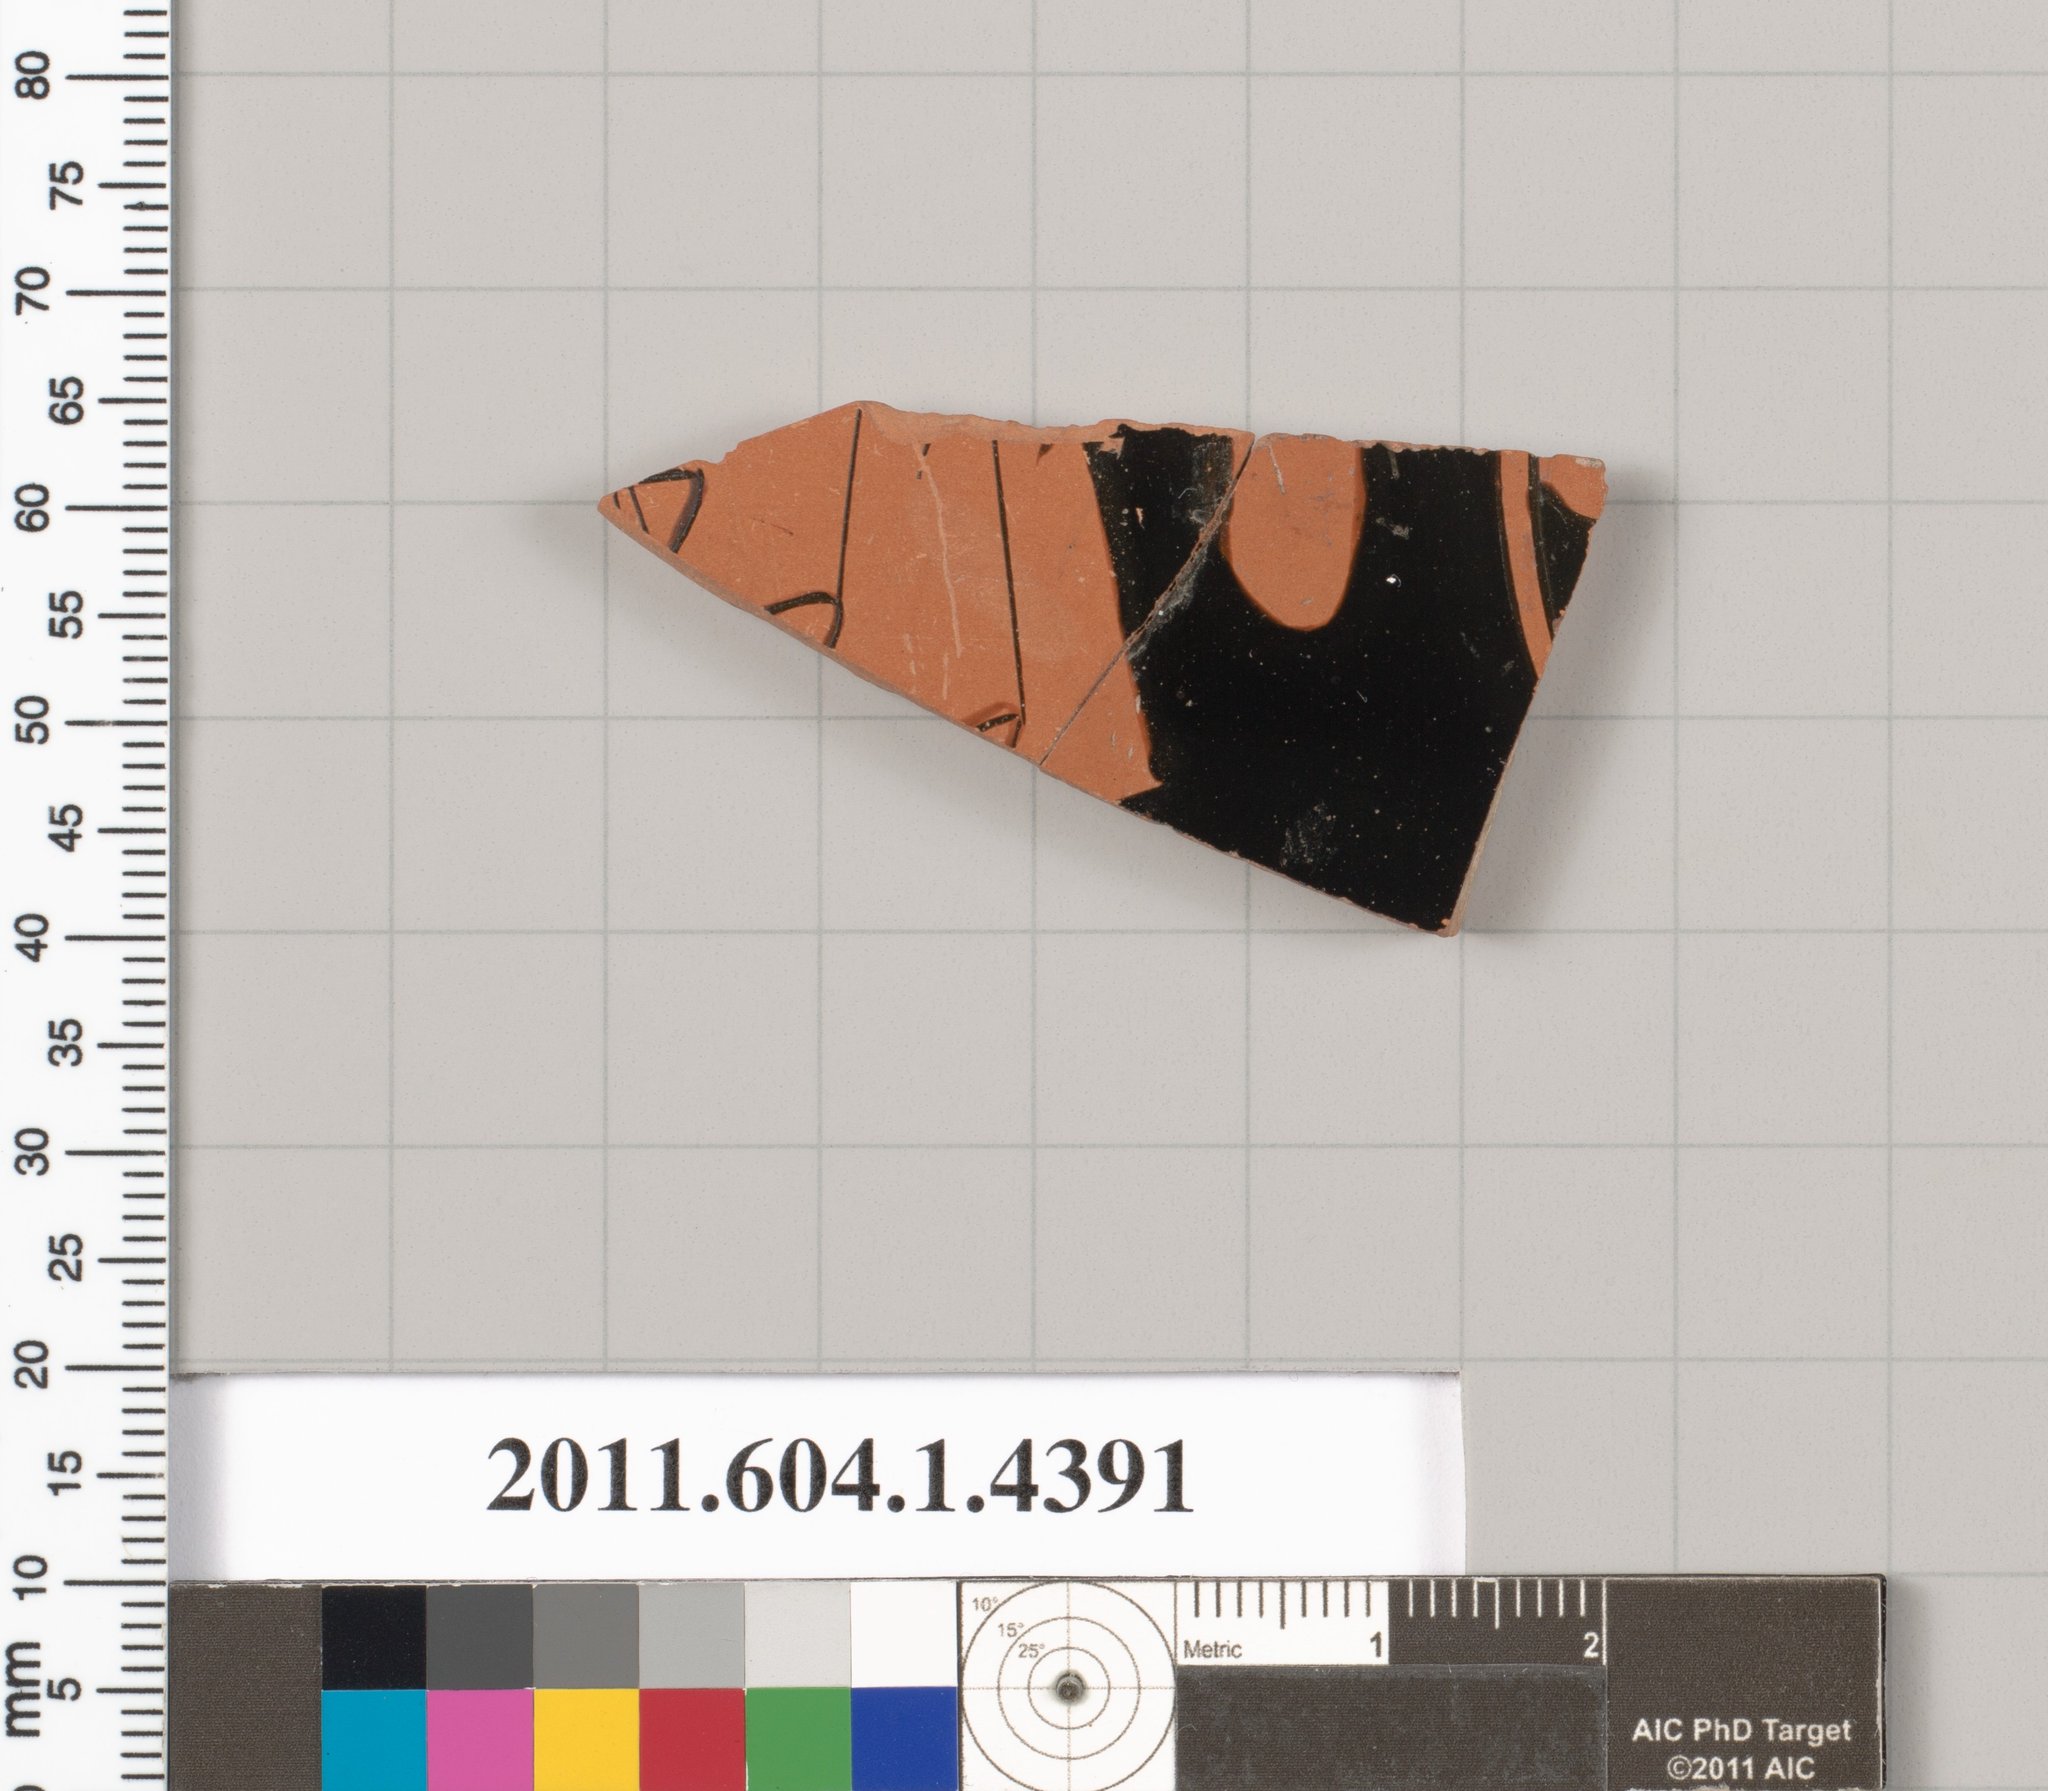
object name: kylix fragment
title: Terracotta fragment of a kylix (drinking cup)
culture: greek, attic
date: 500-476 BCE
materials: terracotta